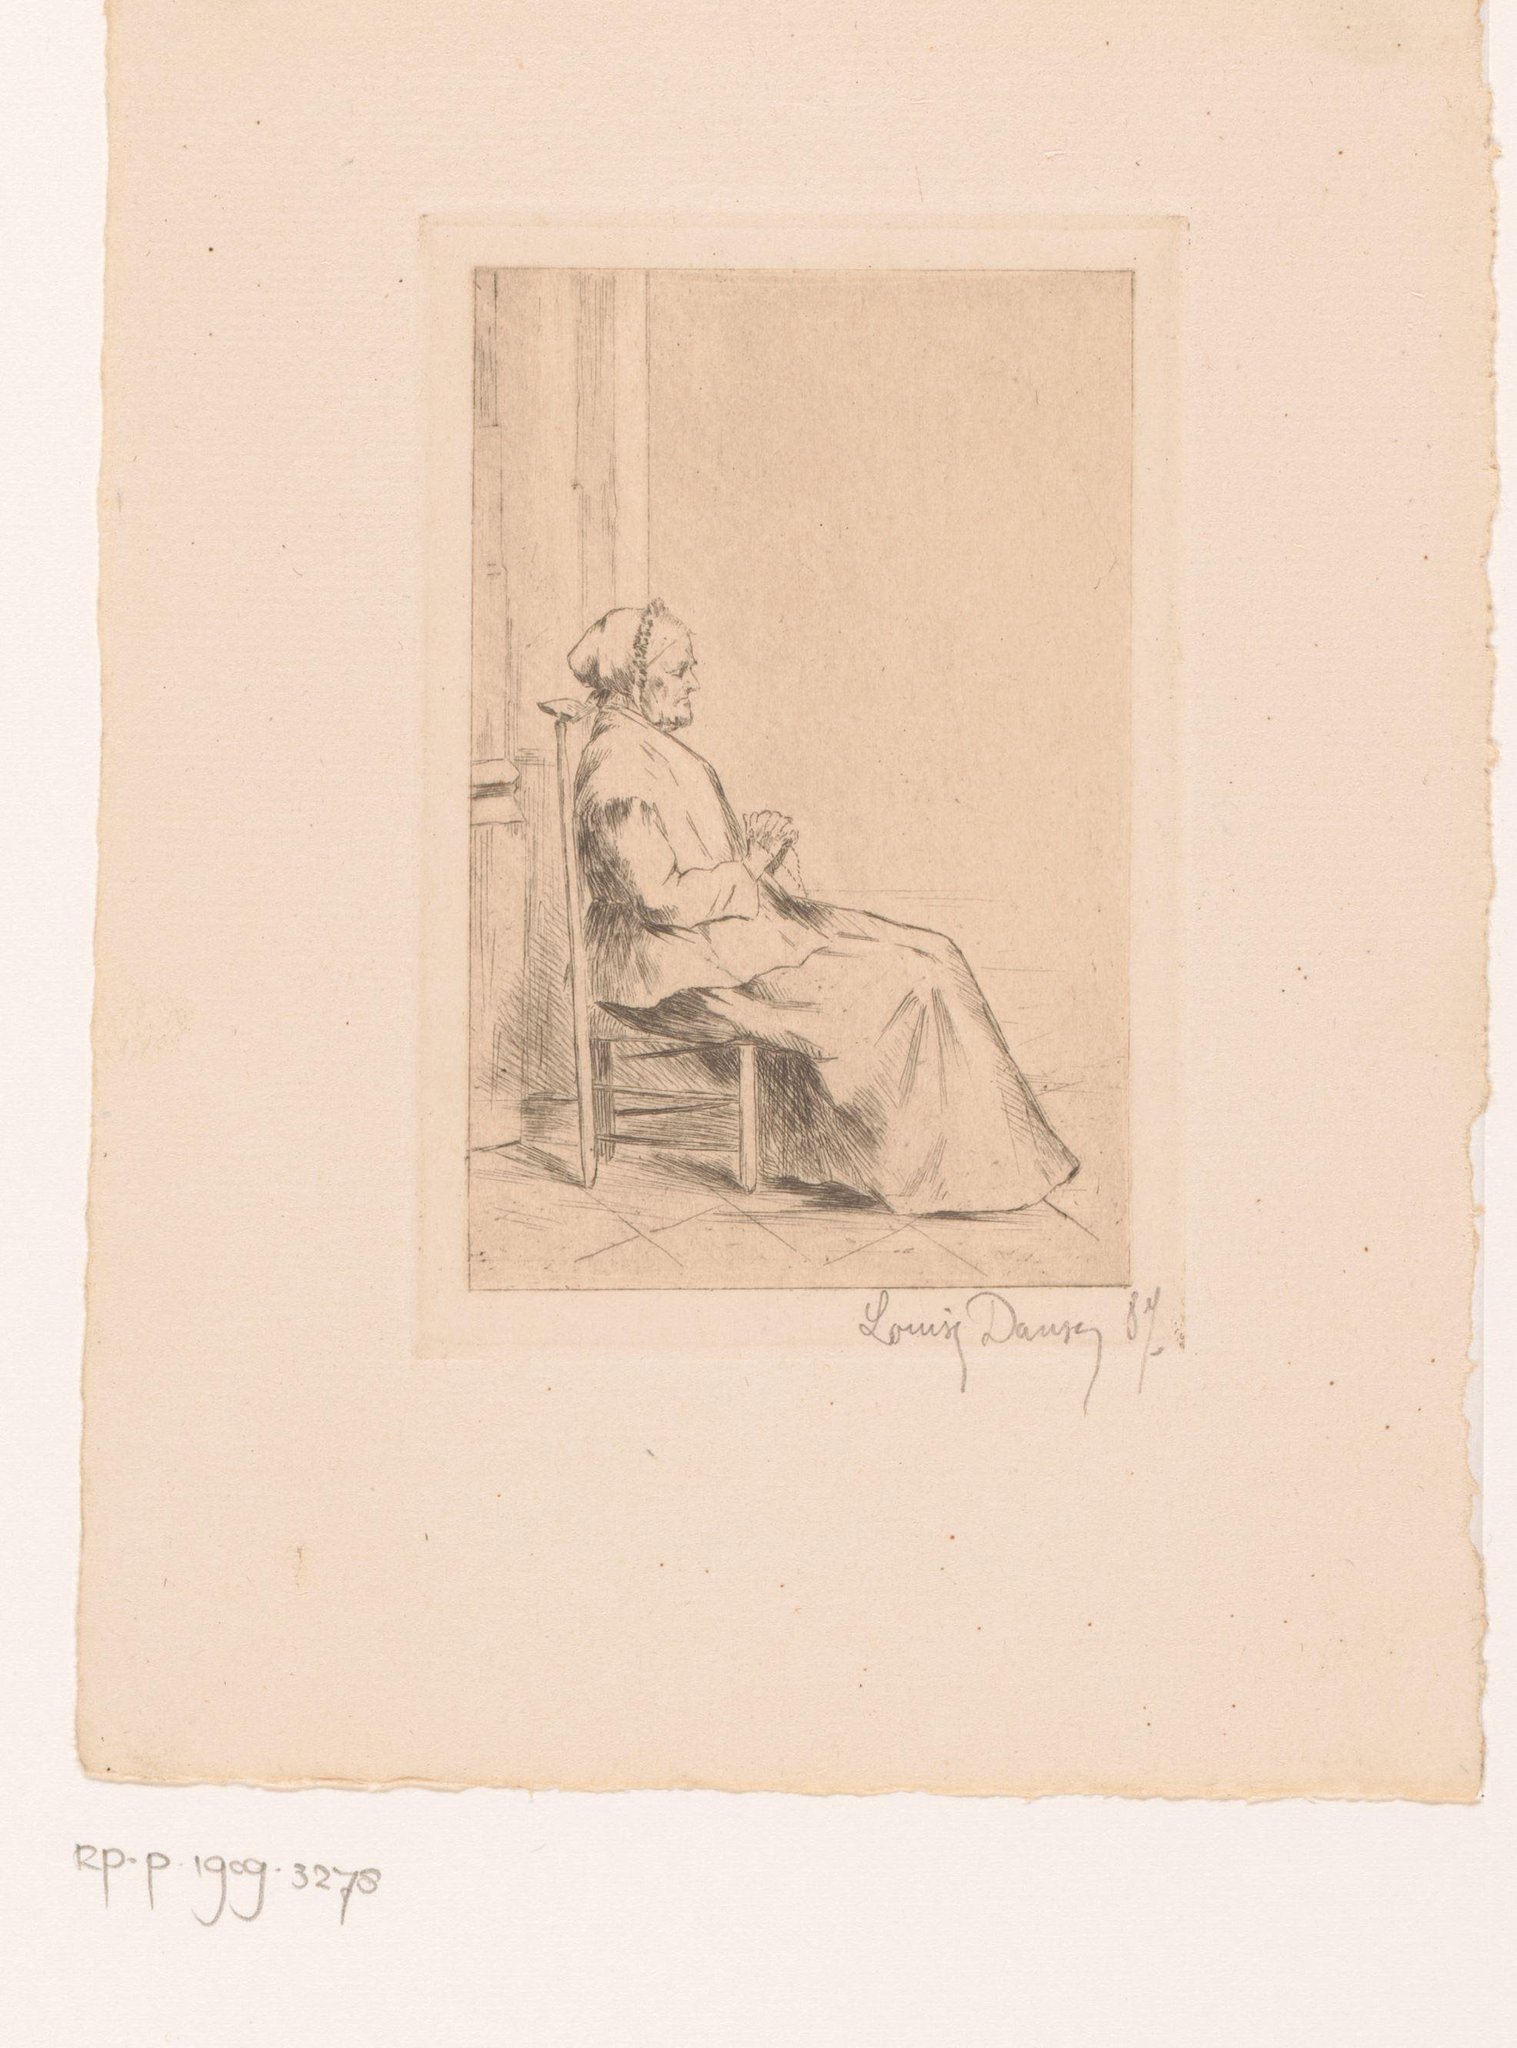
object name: print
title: Oude vrouw met rozenkrans tussen gevouwen handen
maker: louise danse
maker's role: painter, print maker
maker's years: 1867-1948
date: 1887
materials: paper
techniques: etching, intaglio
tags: saying the rosary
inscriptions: collector's mark: Lugt 2228